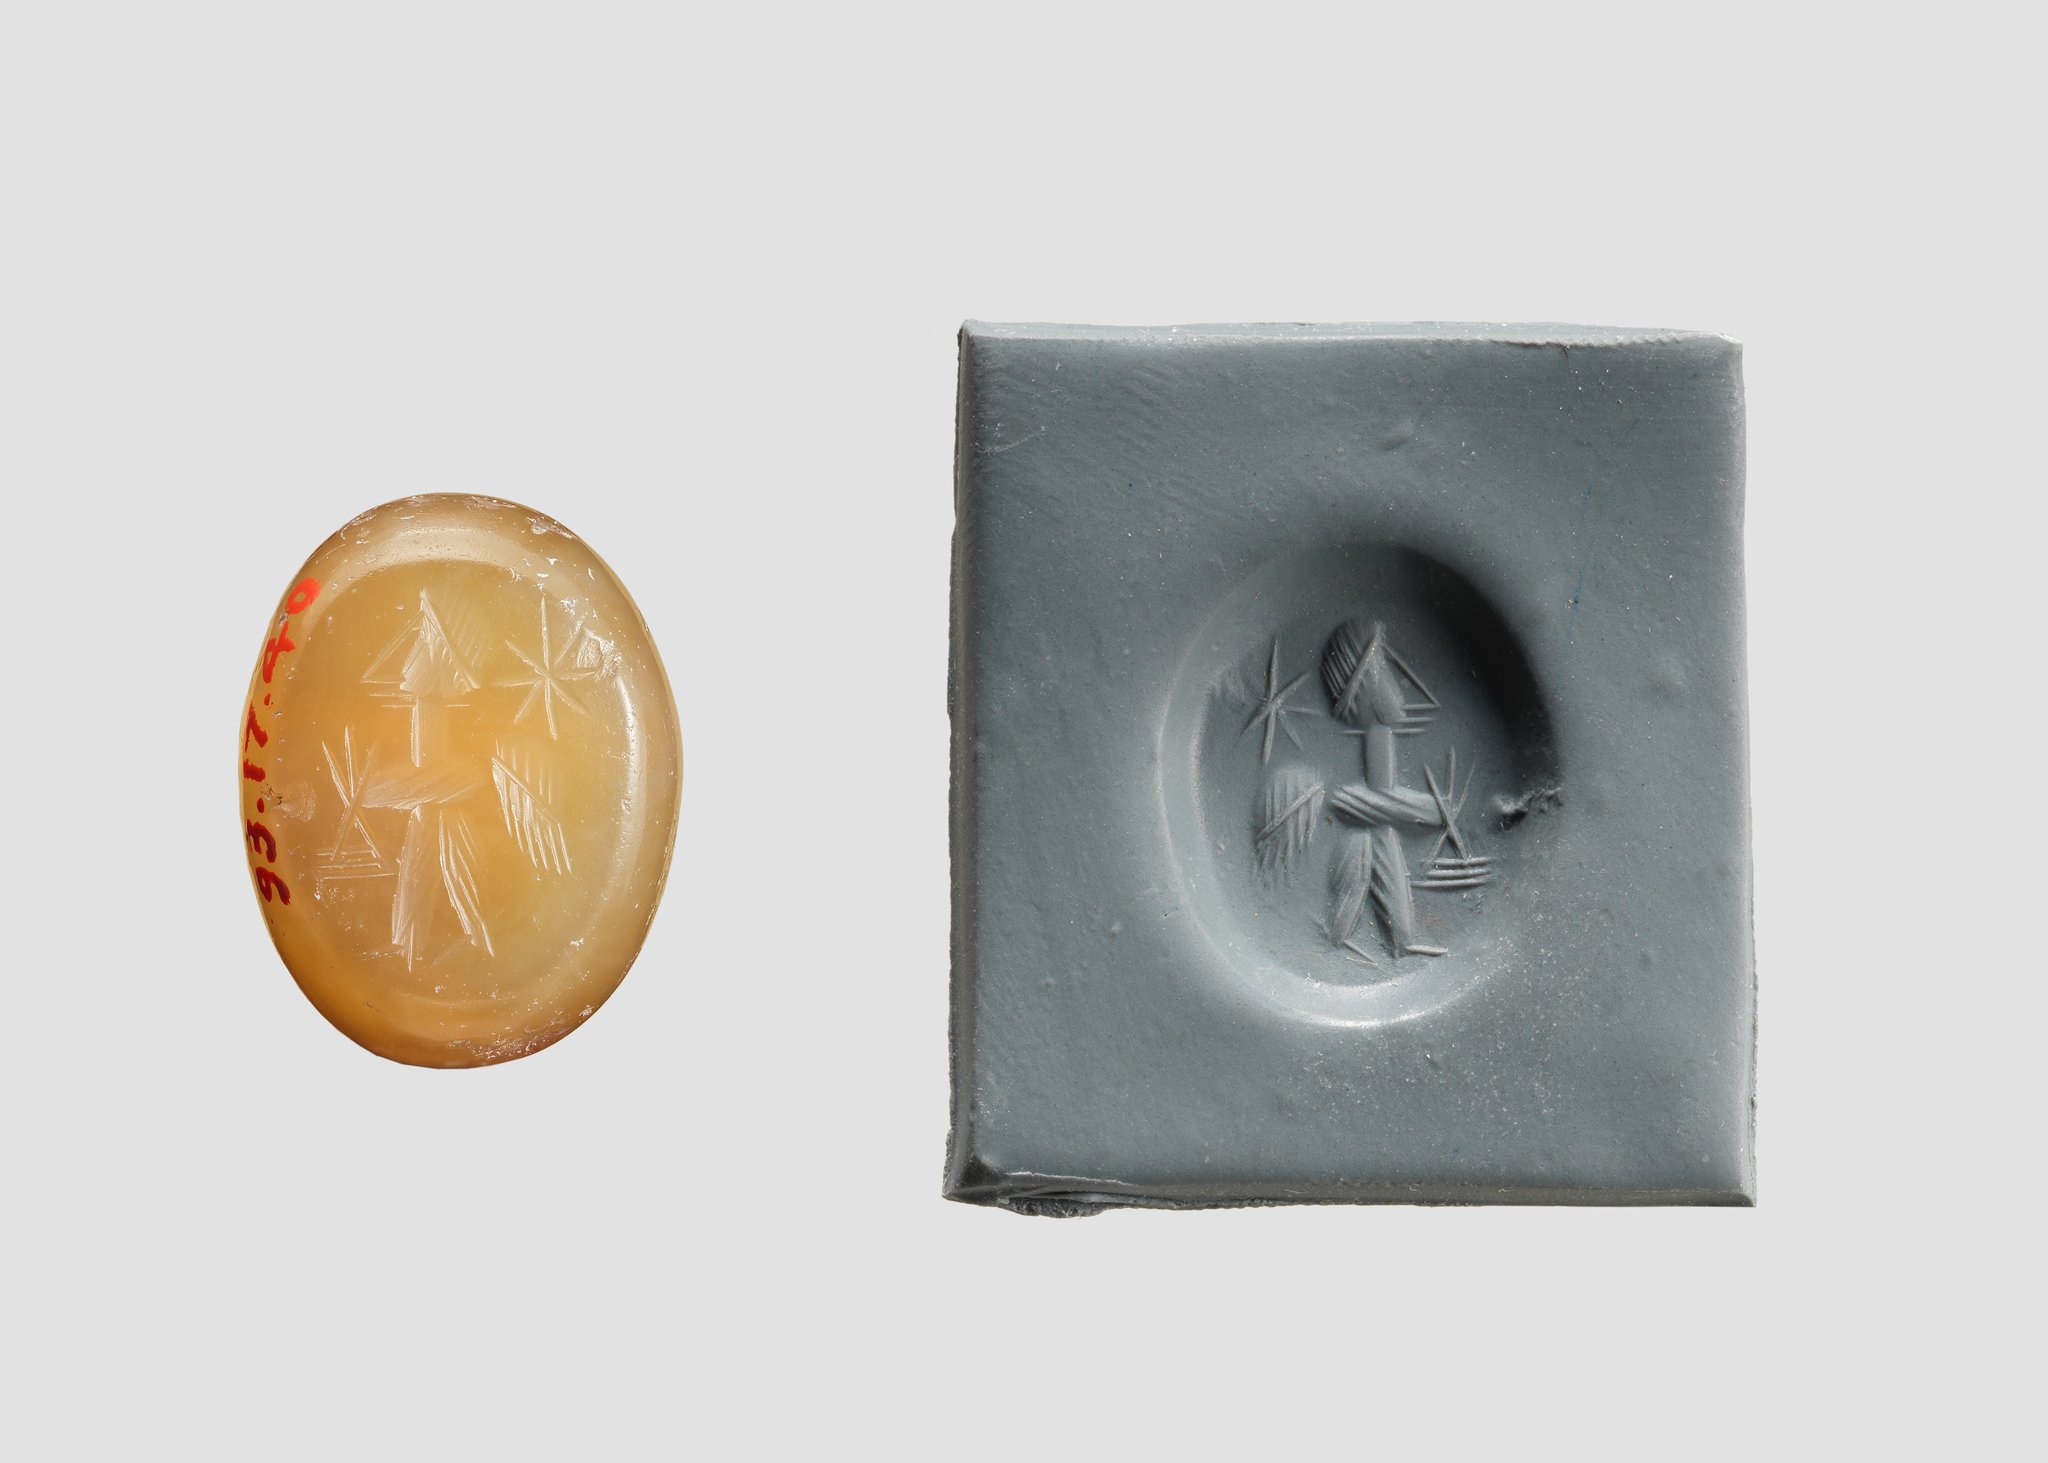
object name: stamp seal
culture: sasanian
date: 201-700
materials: stone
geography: iran or mesopotamia